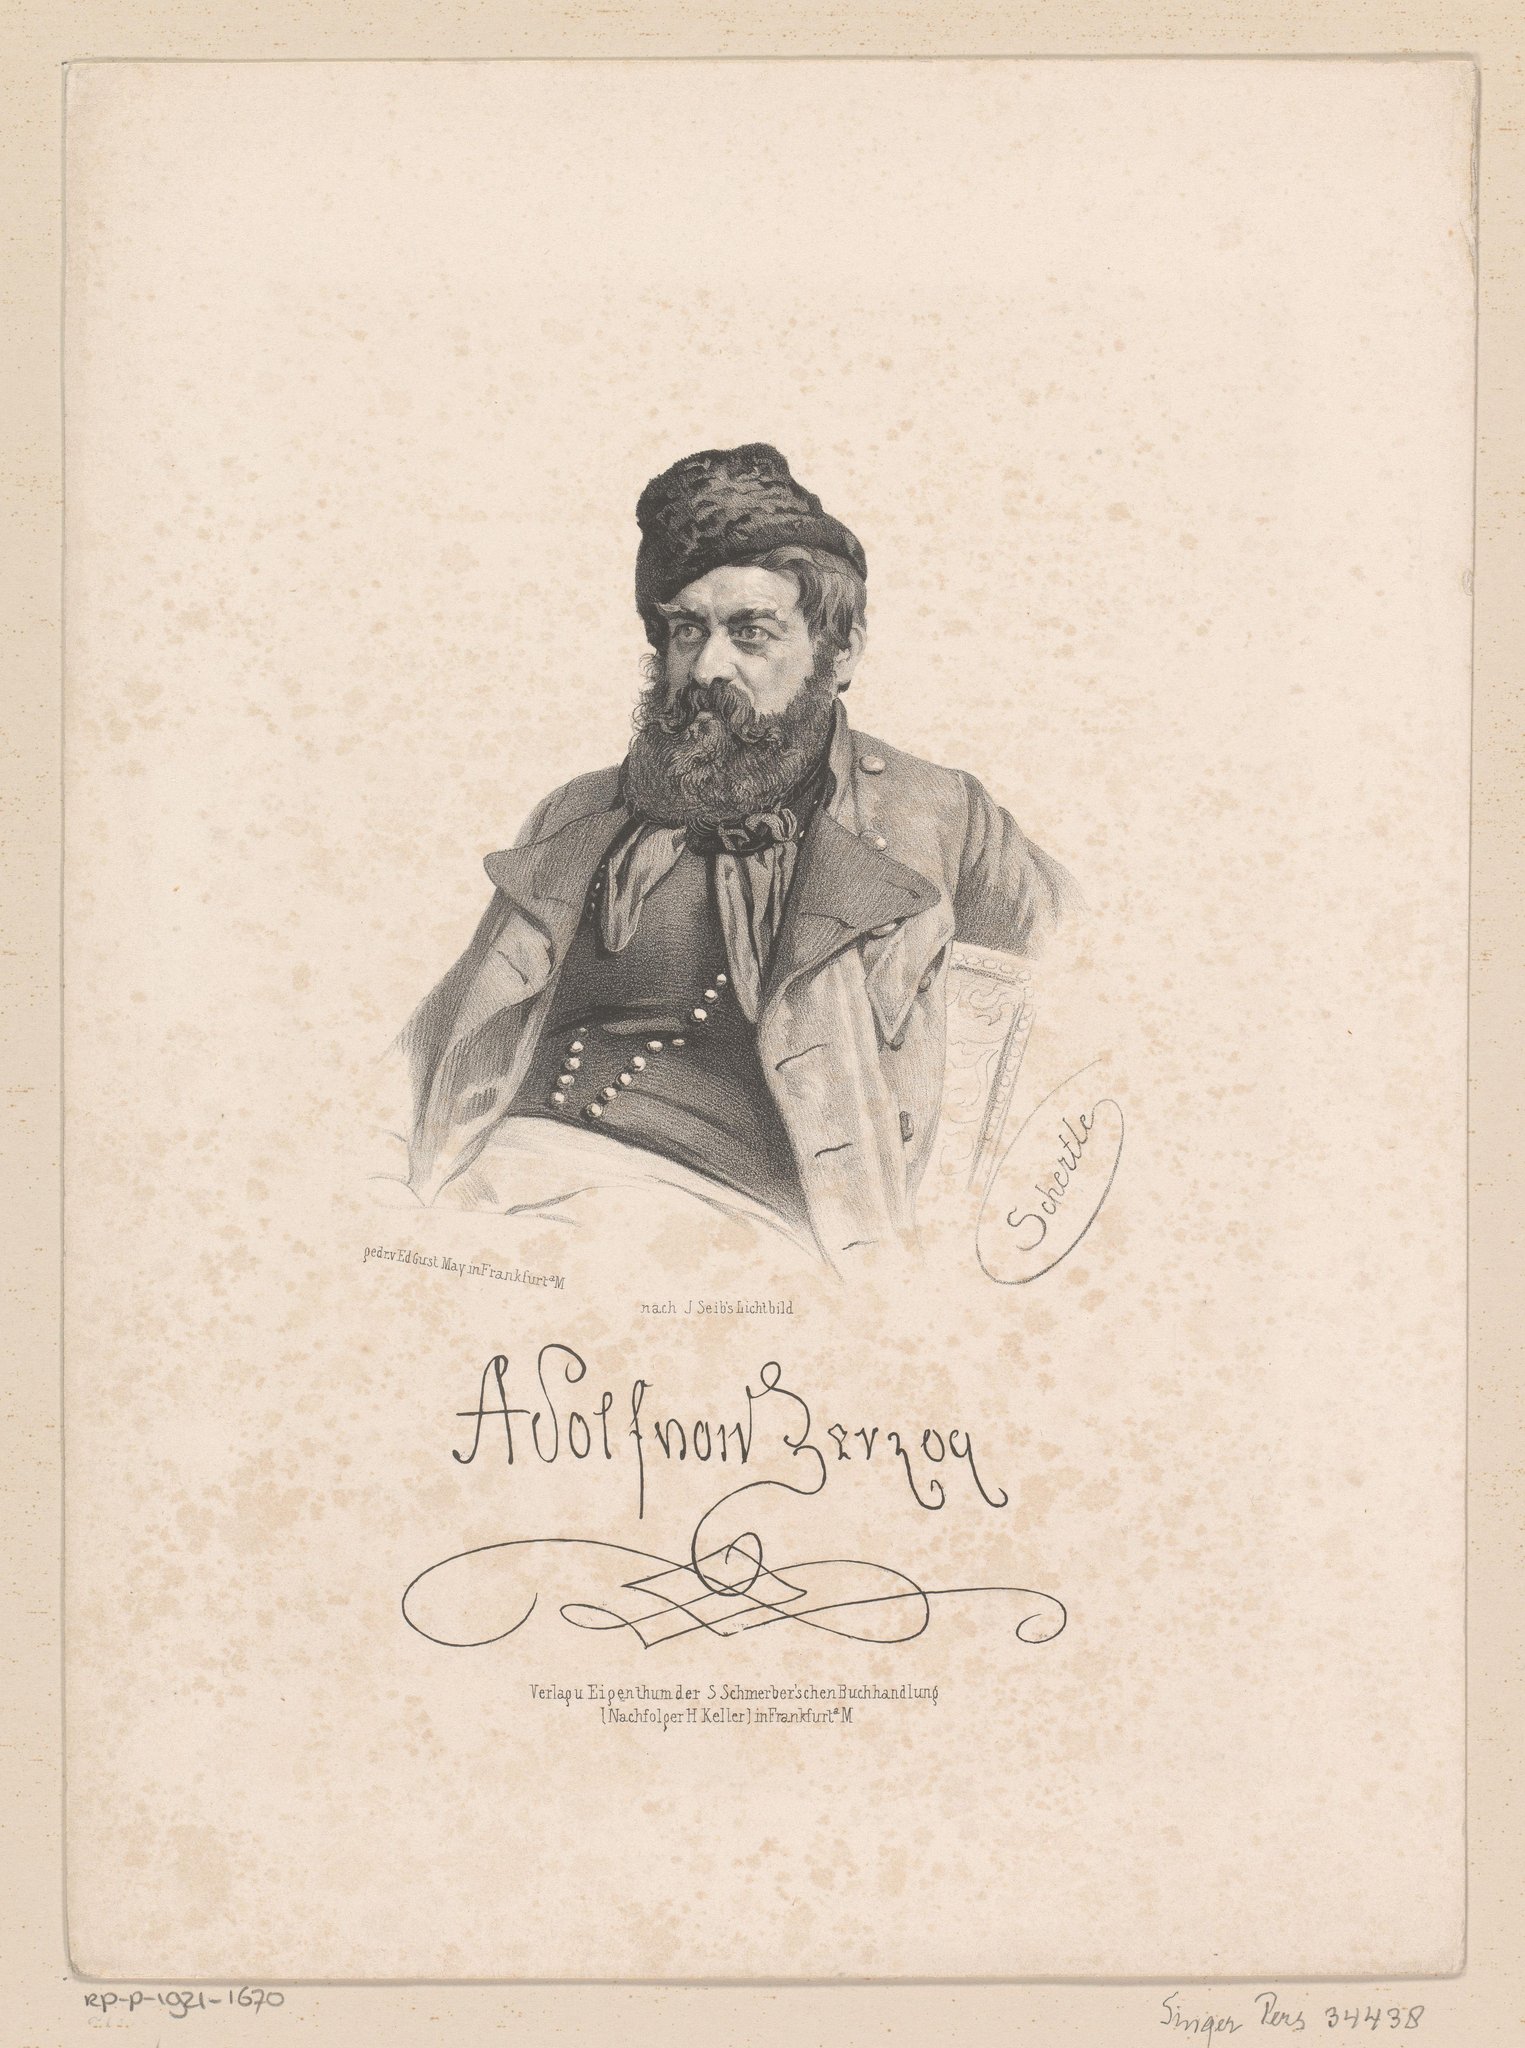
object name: print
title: Portret van Adolf von Zerzog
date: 1845-1855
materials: paper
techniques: lithograph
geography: frankfurt am main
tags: politician, historical persons, politician, e.g. party leader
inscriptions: collector's mark: Lugt 2233